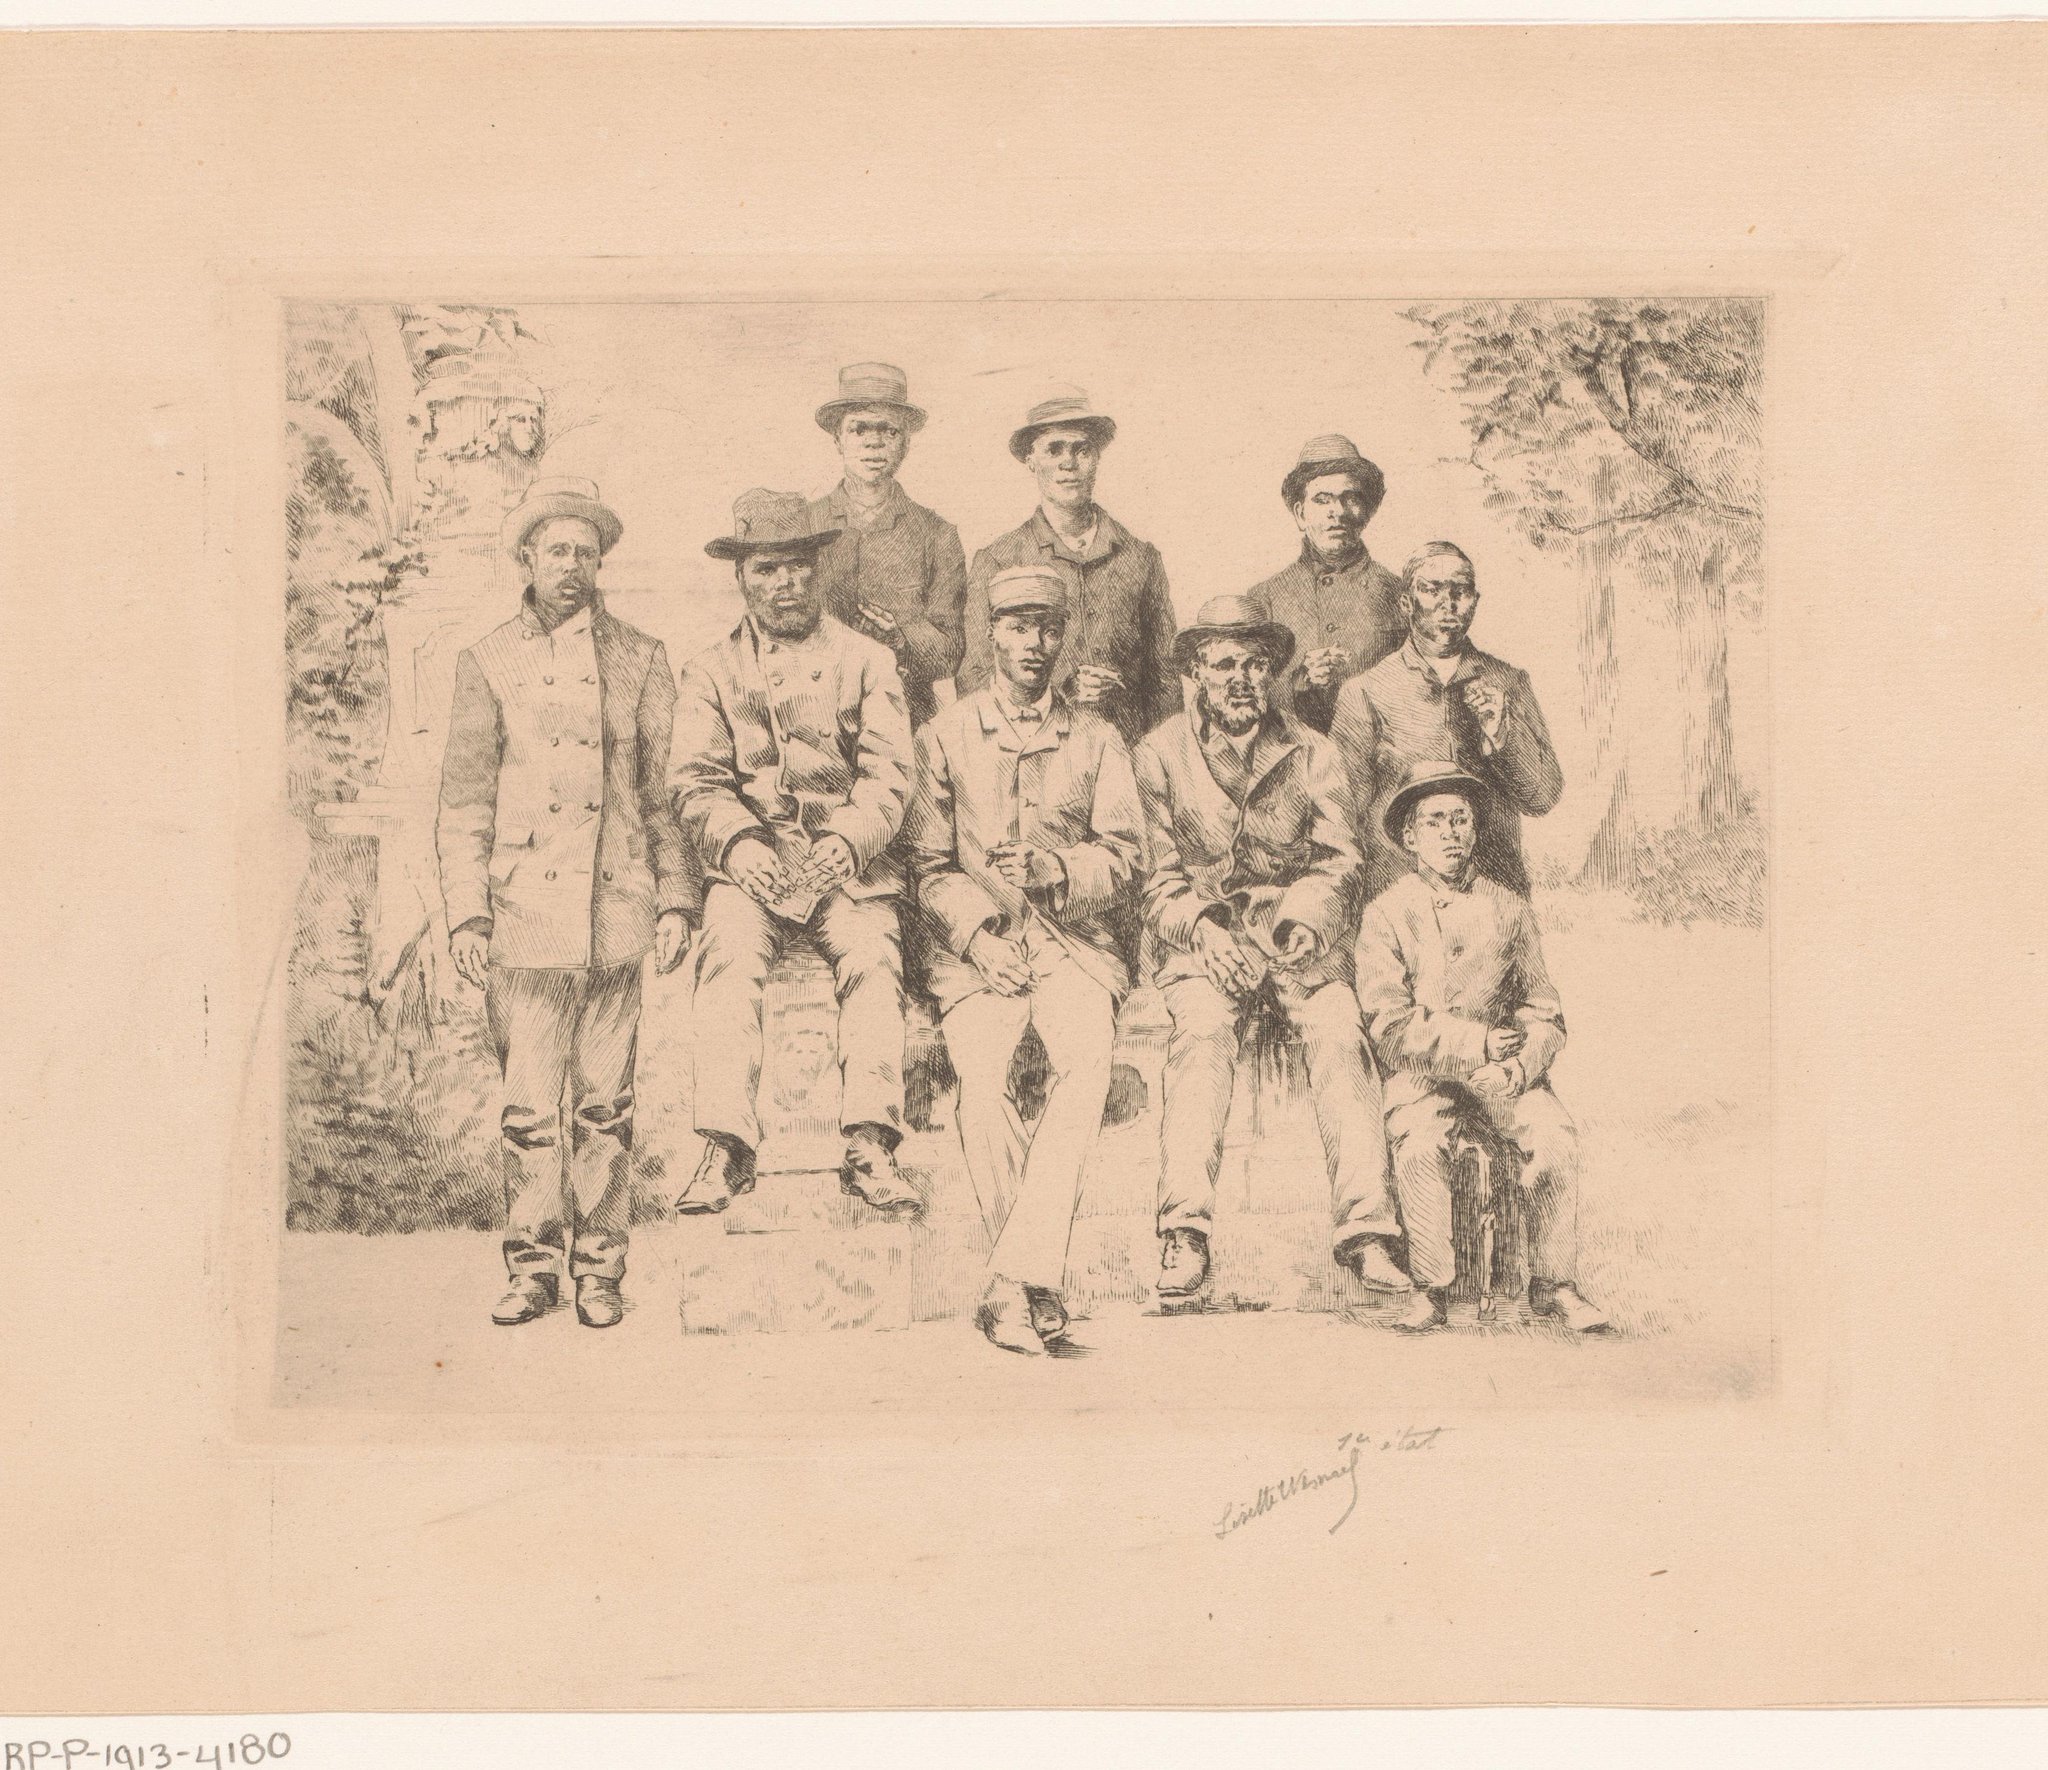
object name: print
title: Afrikaansche typen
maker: lisette wesmael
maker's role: print maker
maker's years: 1861-1953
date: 1883-1913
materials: paper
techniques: etching, intaglio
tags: africans, anonymous historical persons portrayed in a group, in a group-portrait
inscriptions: collector's mark: Lugt 2228